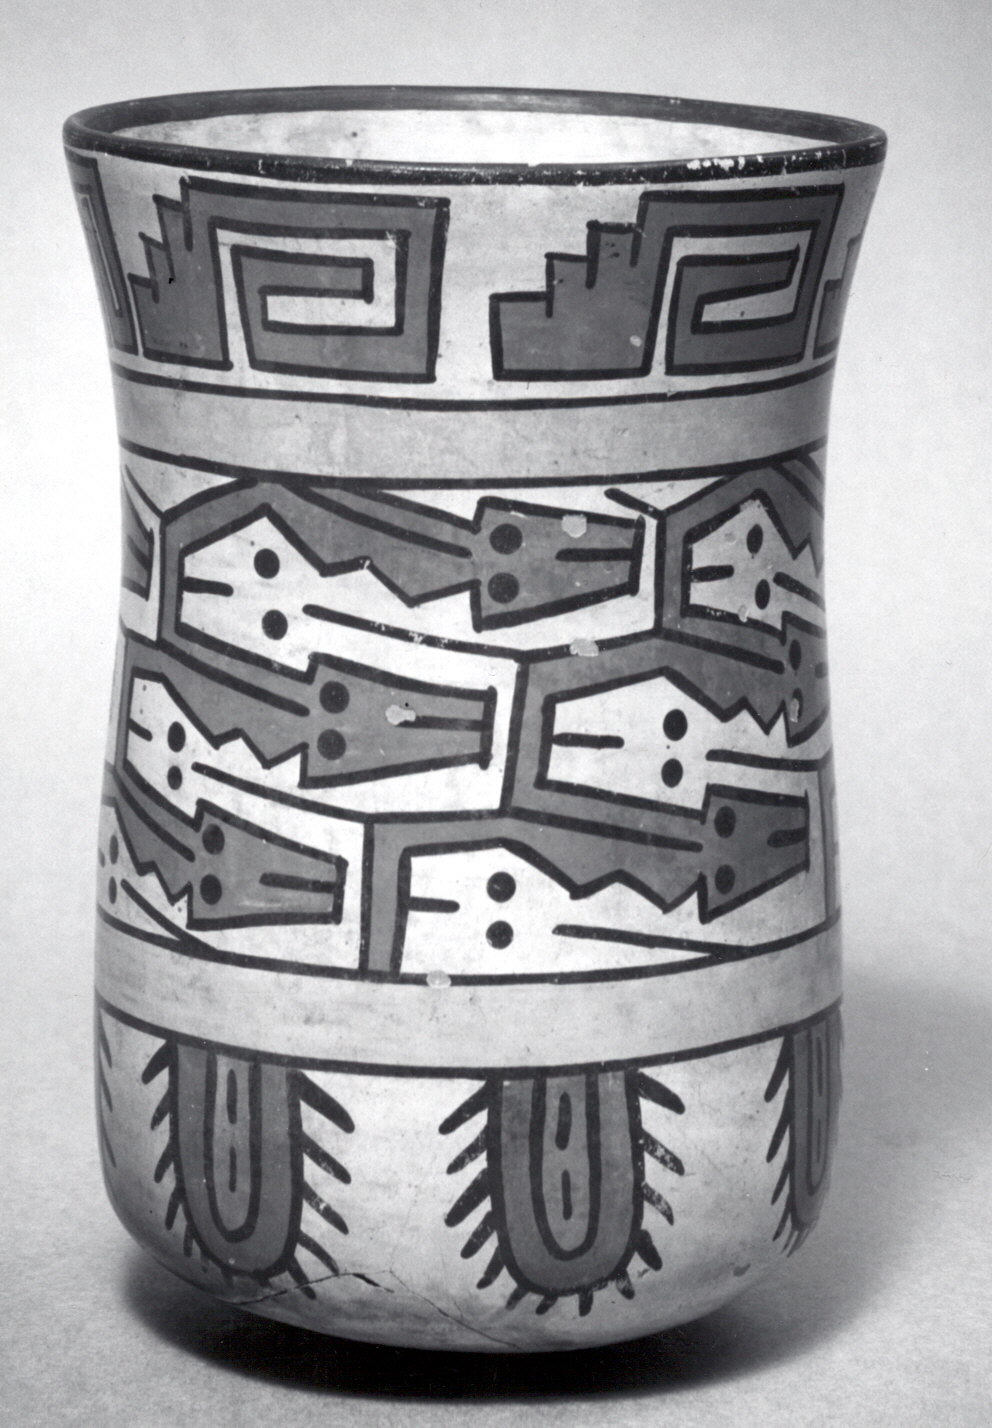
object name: beaker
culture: nasca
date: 1-600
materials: ceramic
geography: peru